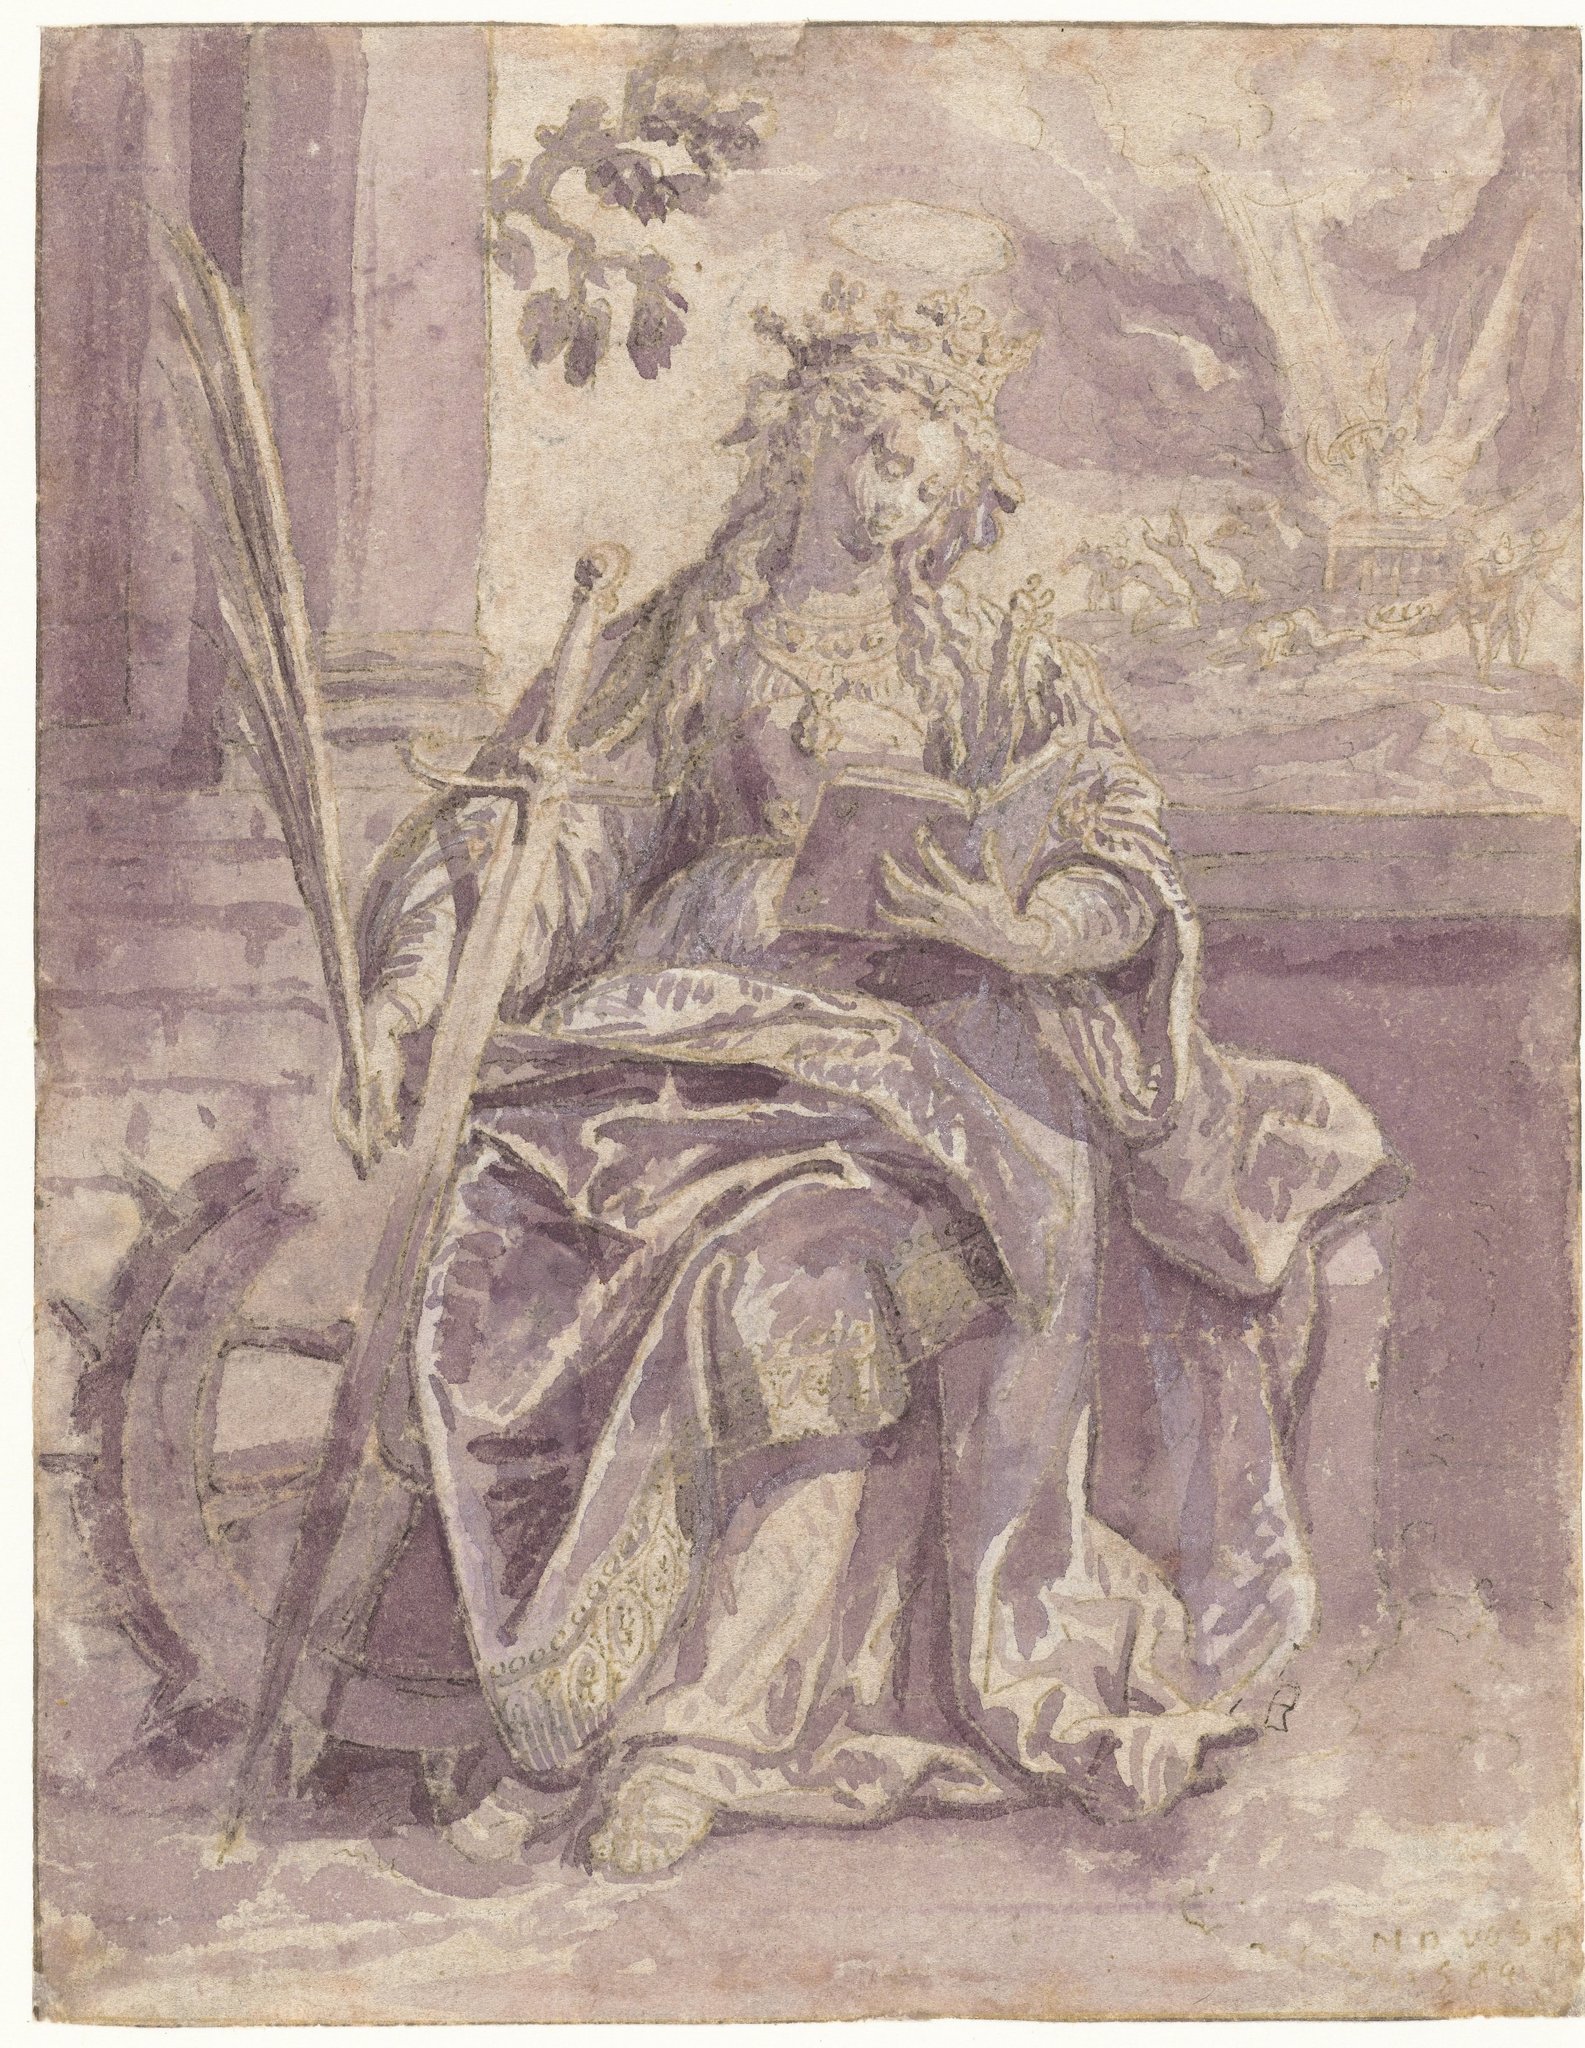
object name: drawing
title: Heilige Catharina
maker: maerten de vos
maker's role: draughtsman, painter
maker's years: 1532-1603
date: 1584-1589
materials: ink, paper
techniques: brush, pen